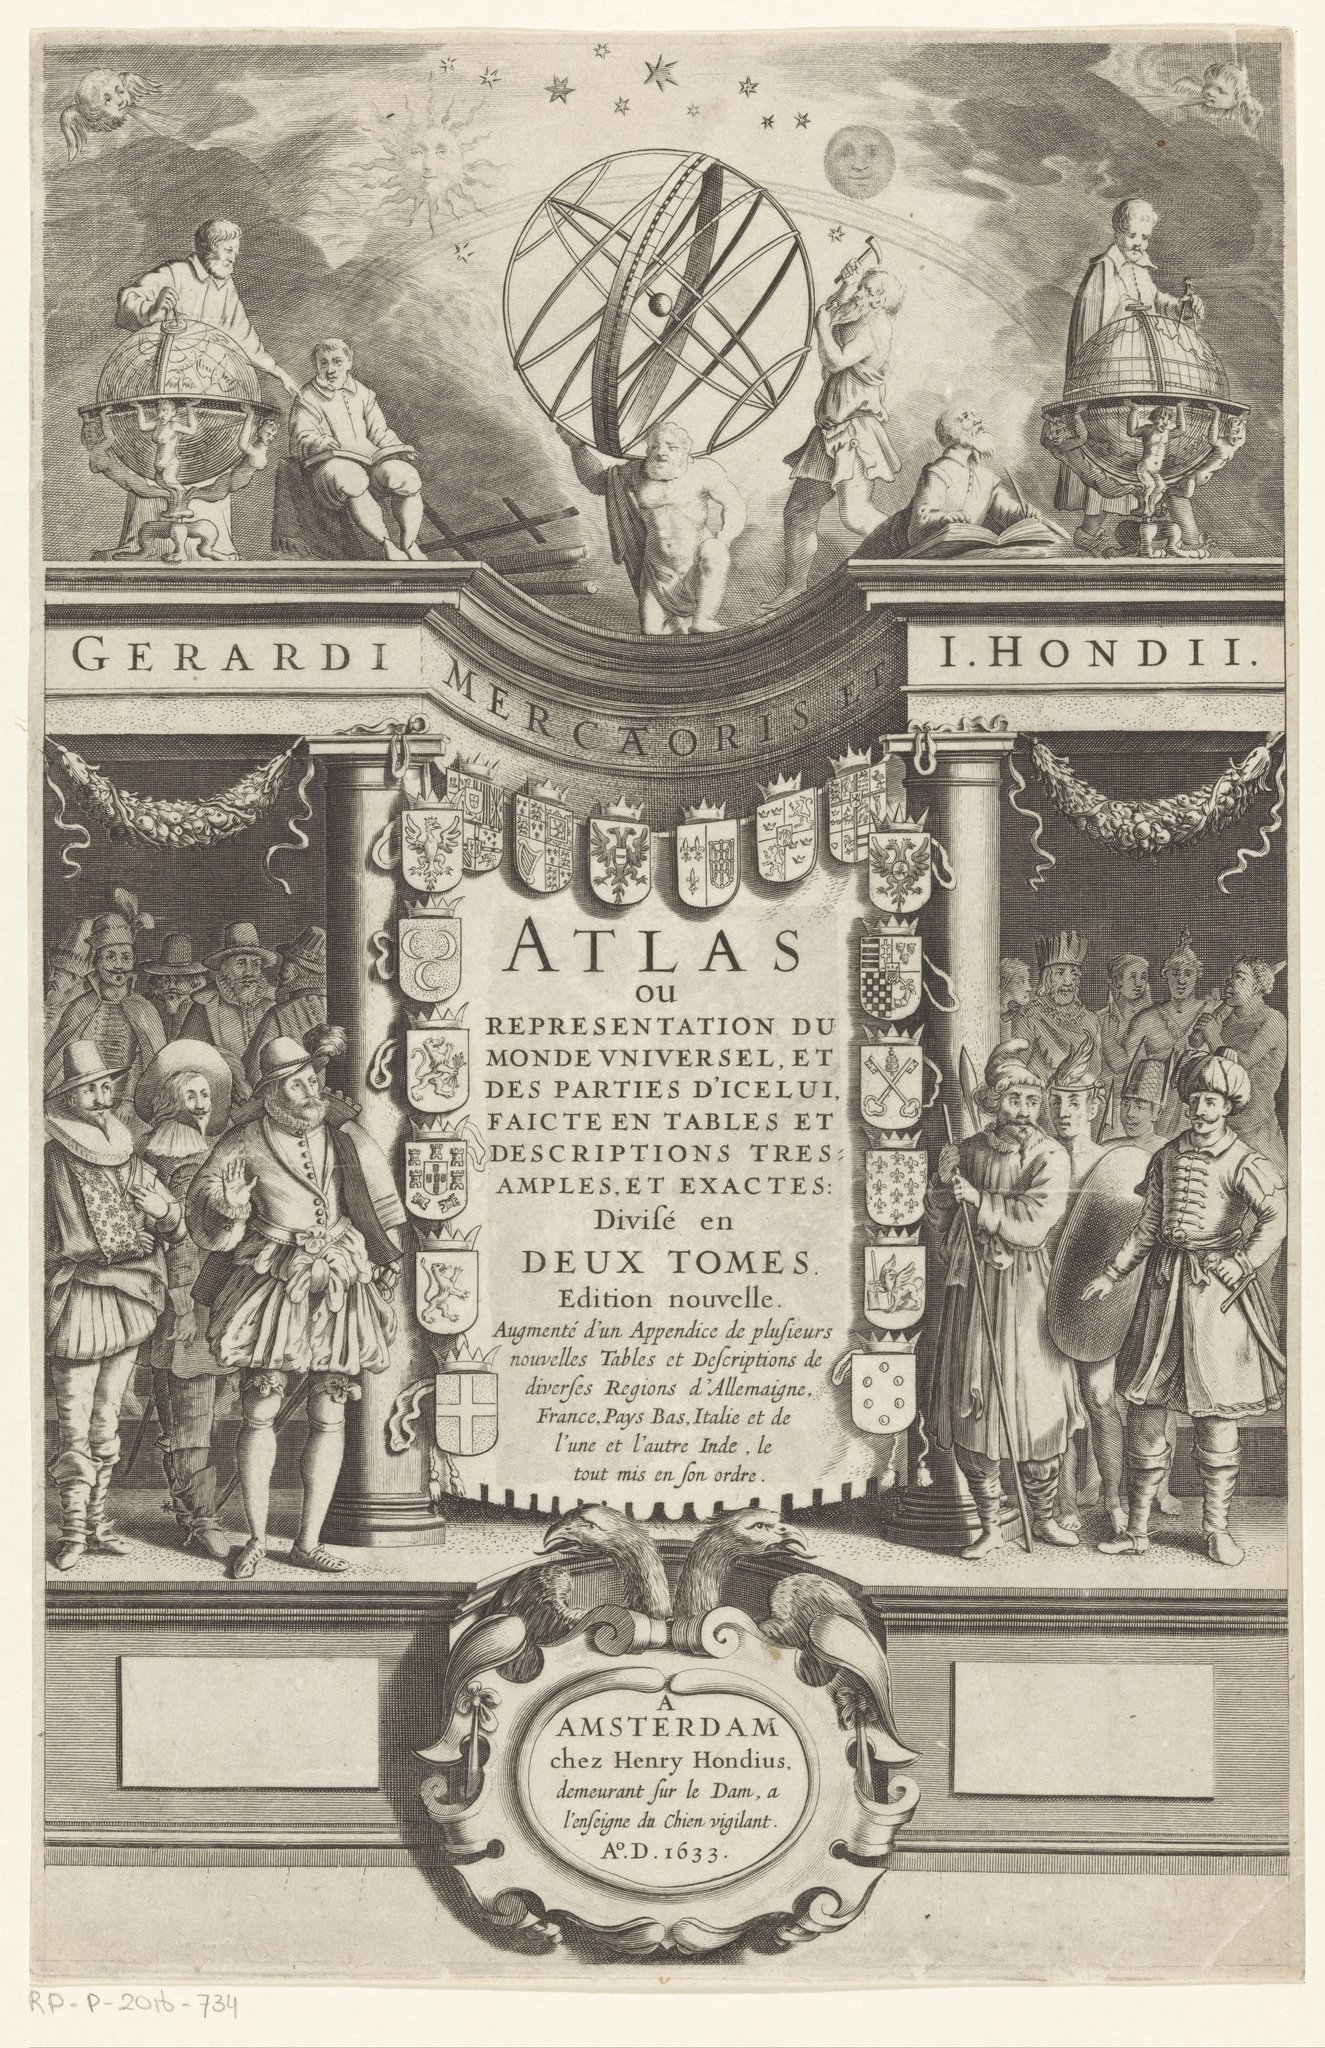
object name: titelblad, titelpagina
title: Titelpagina voor: Gerardus Mercator, Atlas, 1633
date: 1633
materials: paper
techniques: engraving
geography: amsterdam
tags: (story of) atlas, human races, peoples and nationalities (other than prehistoric or extinct)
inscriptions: collector's mark: Lugt 240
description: In het midden de titel omgeven door achttien wapenschilden. Links en rechts mannen en vrouwen als personificaties van diverse bevolkingsgroepen. Aan de bovenzijde de sterrenhemel met in het midden Atlas zitten met een armillarium op zijn rug. Links en rechts van hem een schrijvende man naast een cartograaf bij een globe.